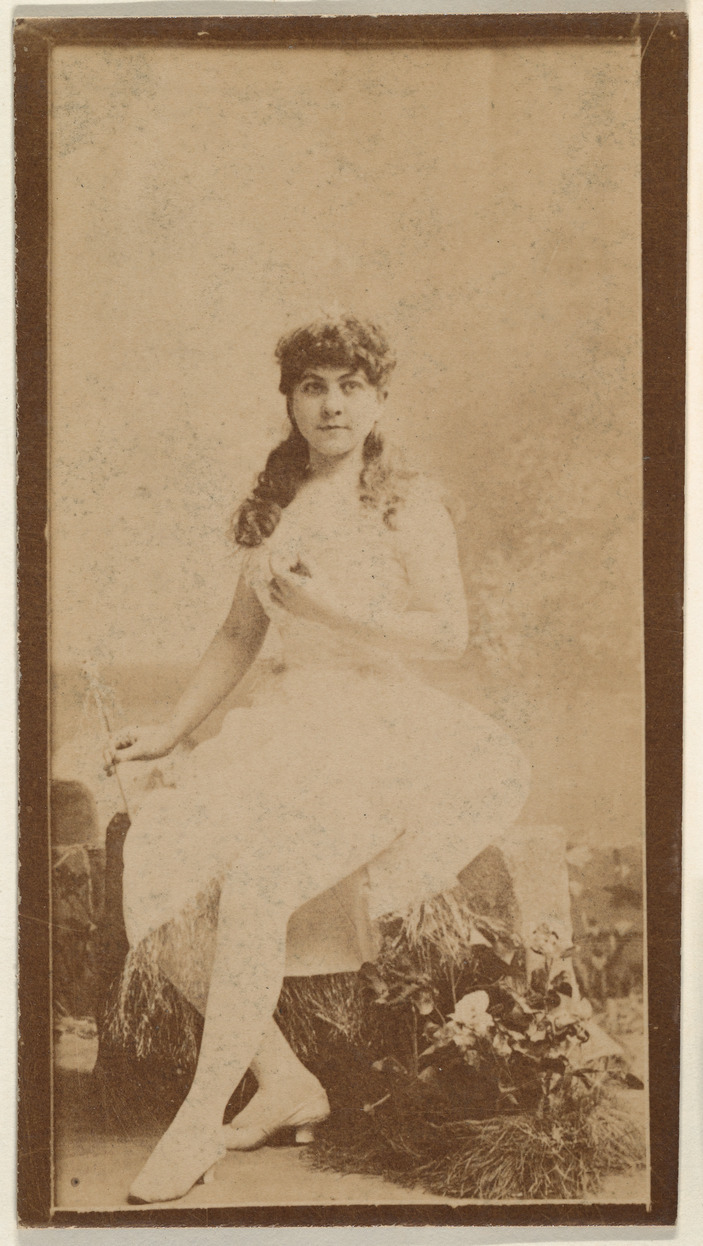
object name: photograph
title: Seated actress, from the Actresses series (N668)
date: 1888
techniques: albumen silver print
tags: portraits,women,actresses